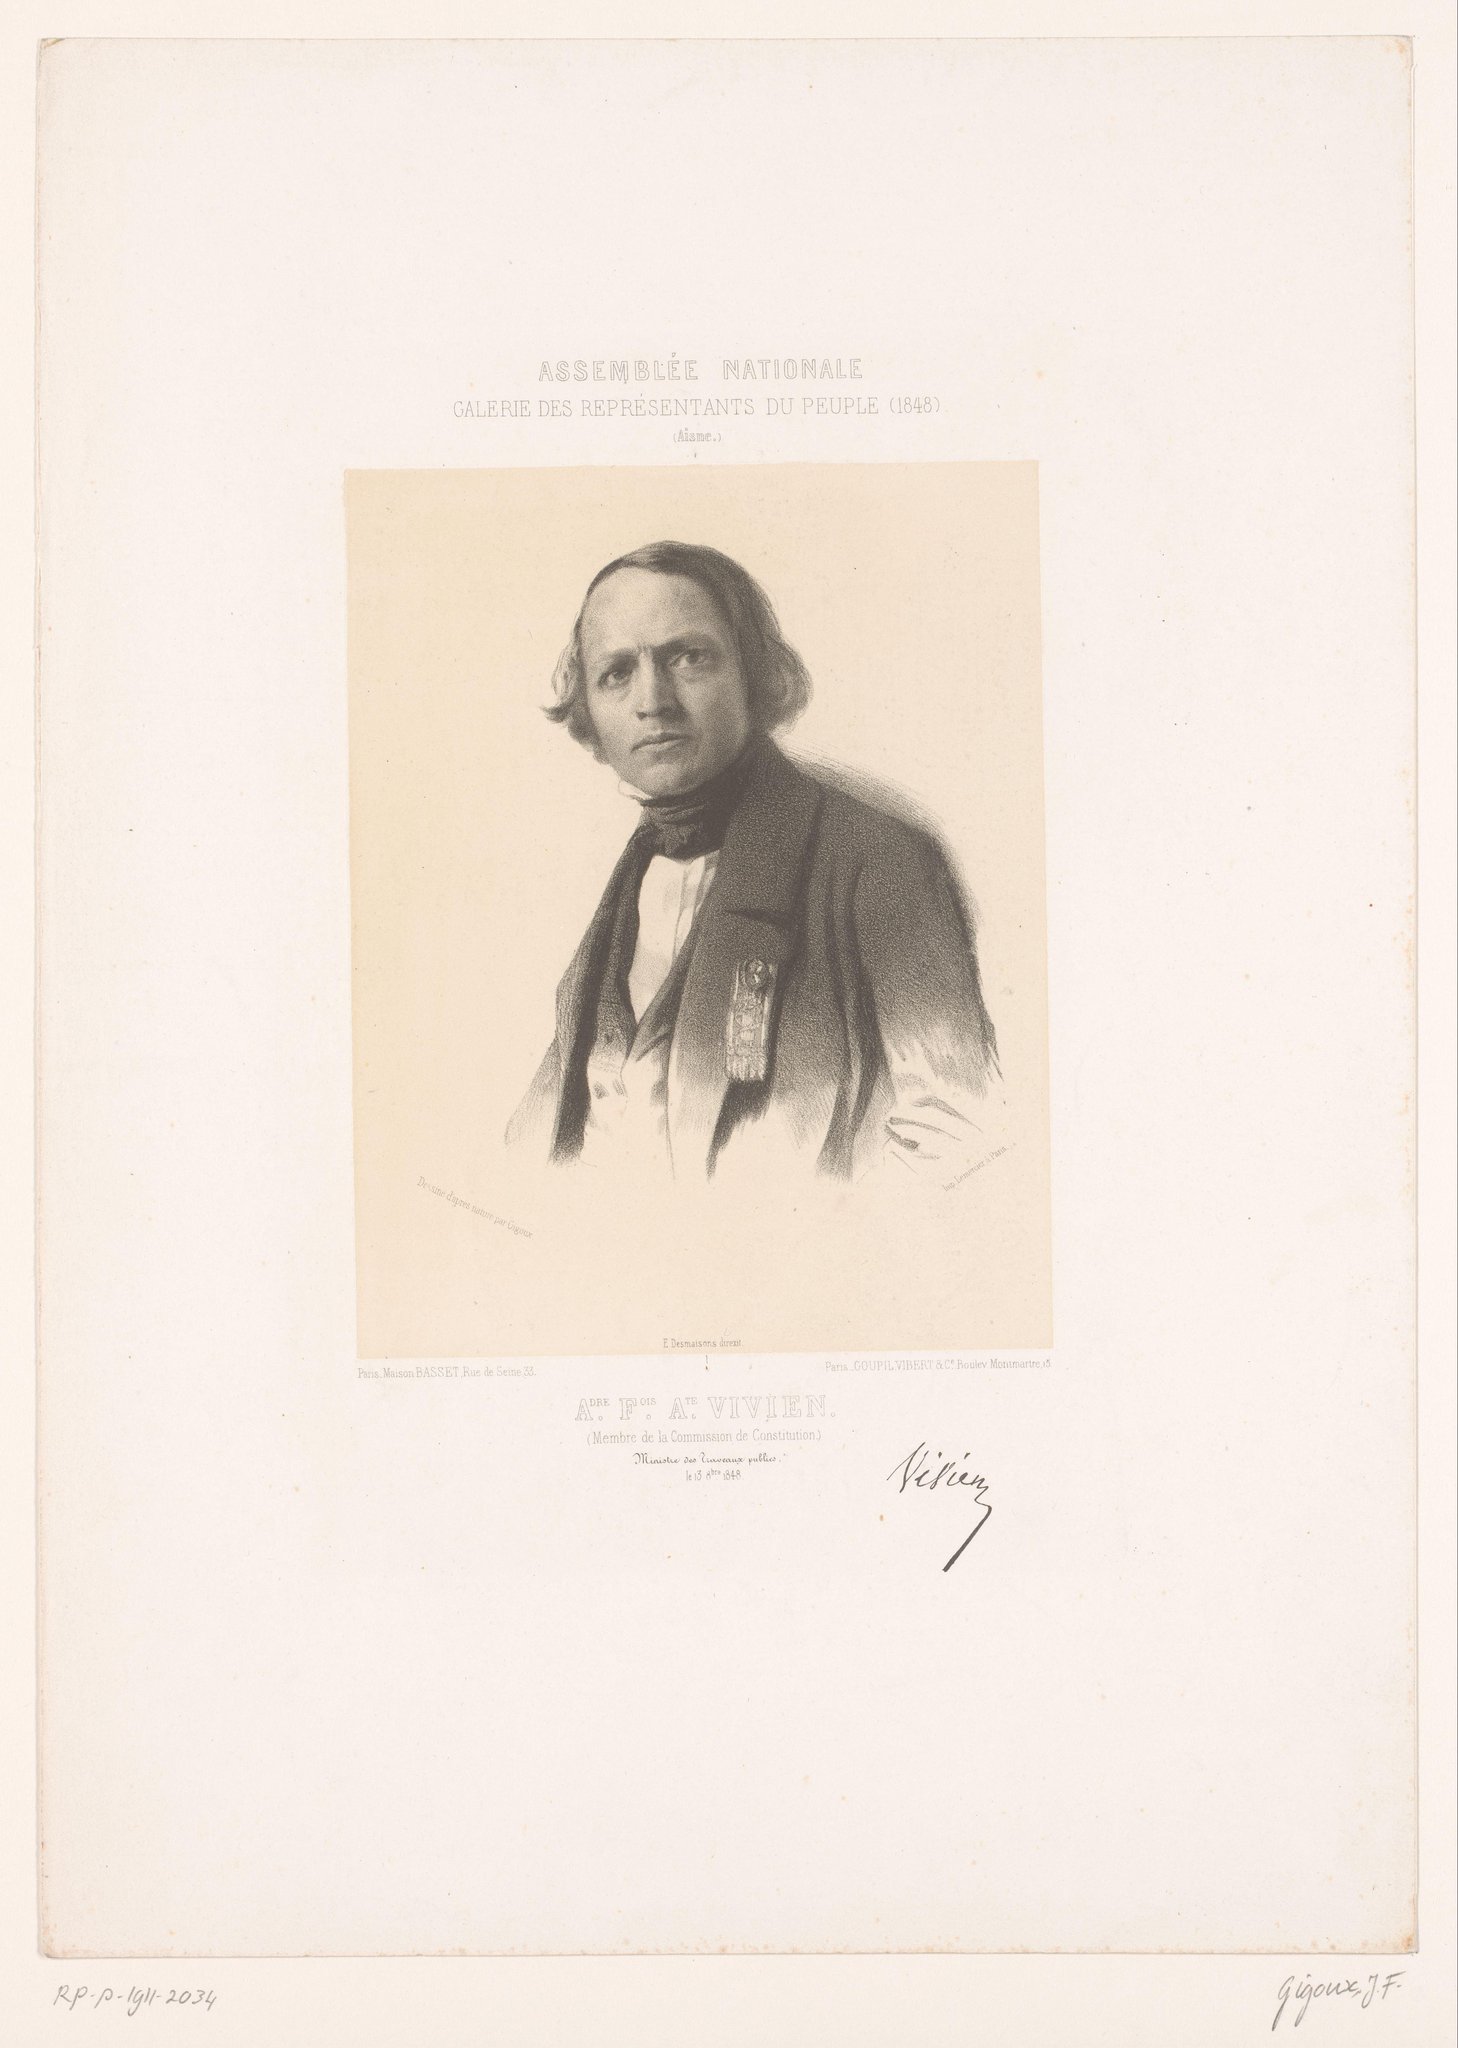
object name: print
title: Adre. Fois. Ate. Vivien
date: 1848-1849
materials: paper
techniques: lithograph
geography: paris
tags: politician, historical persons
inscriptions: collector's mark: Lugt 2228a